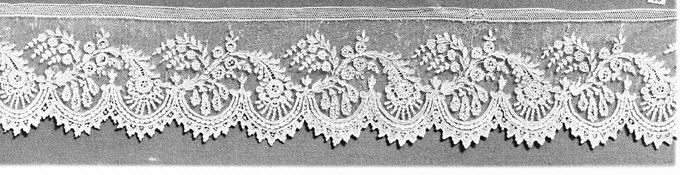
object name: fragment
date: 1801-1900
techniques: lace